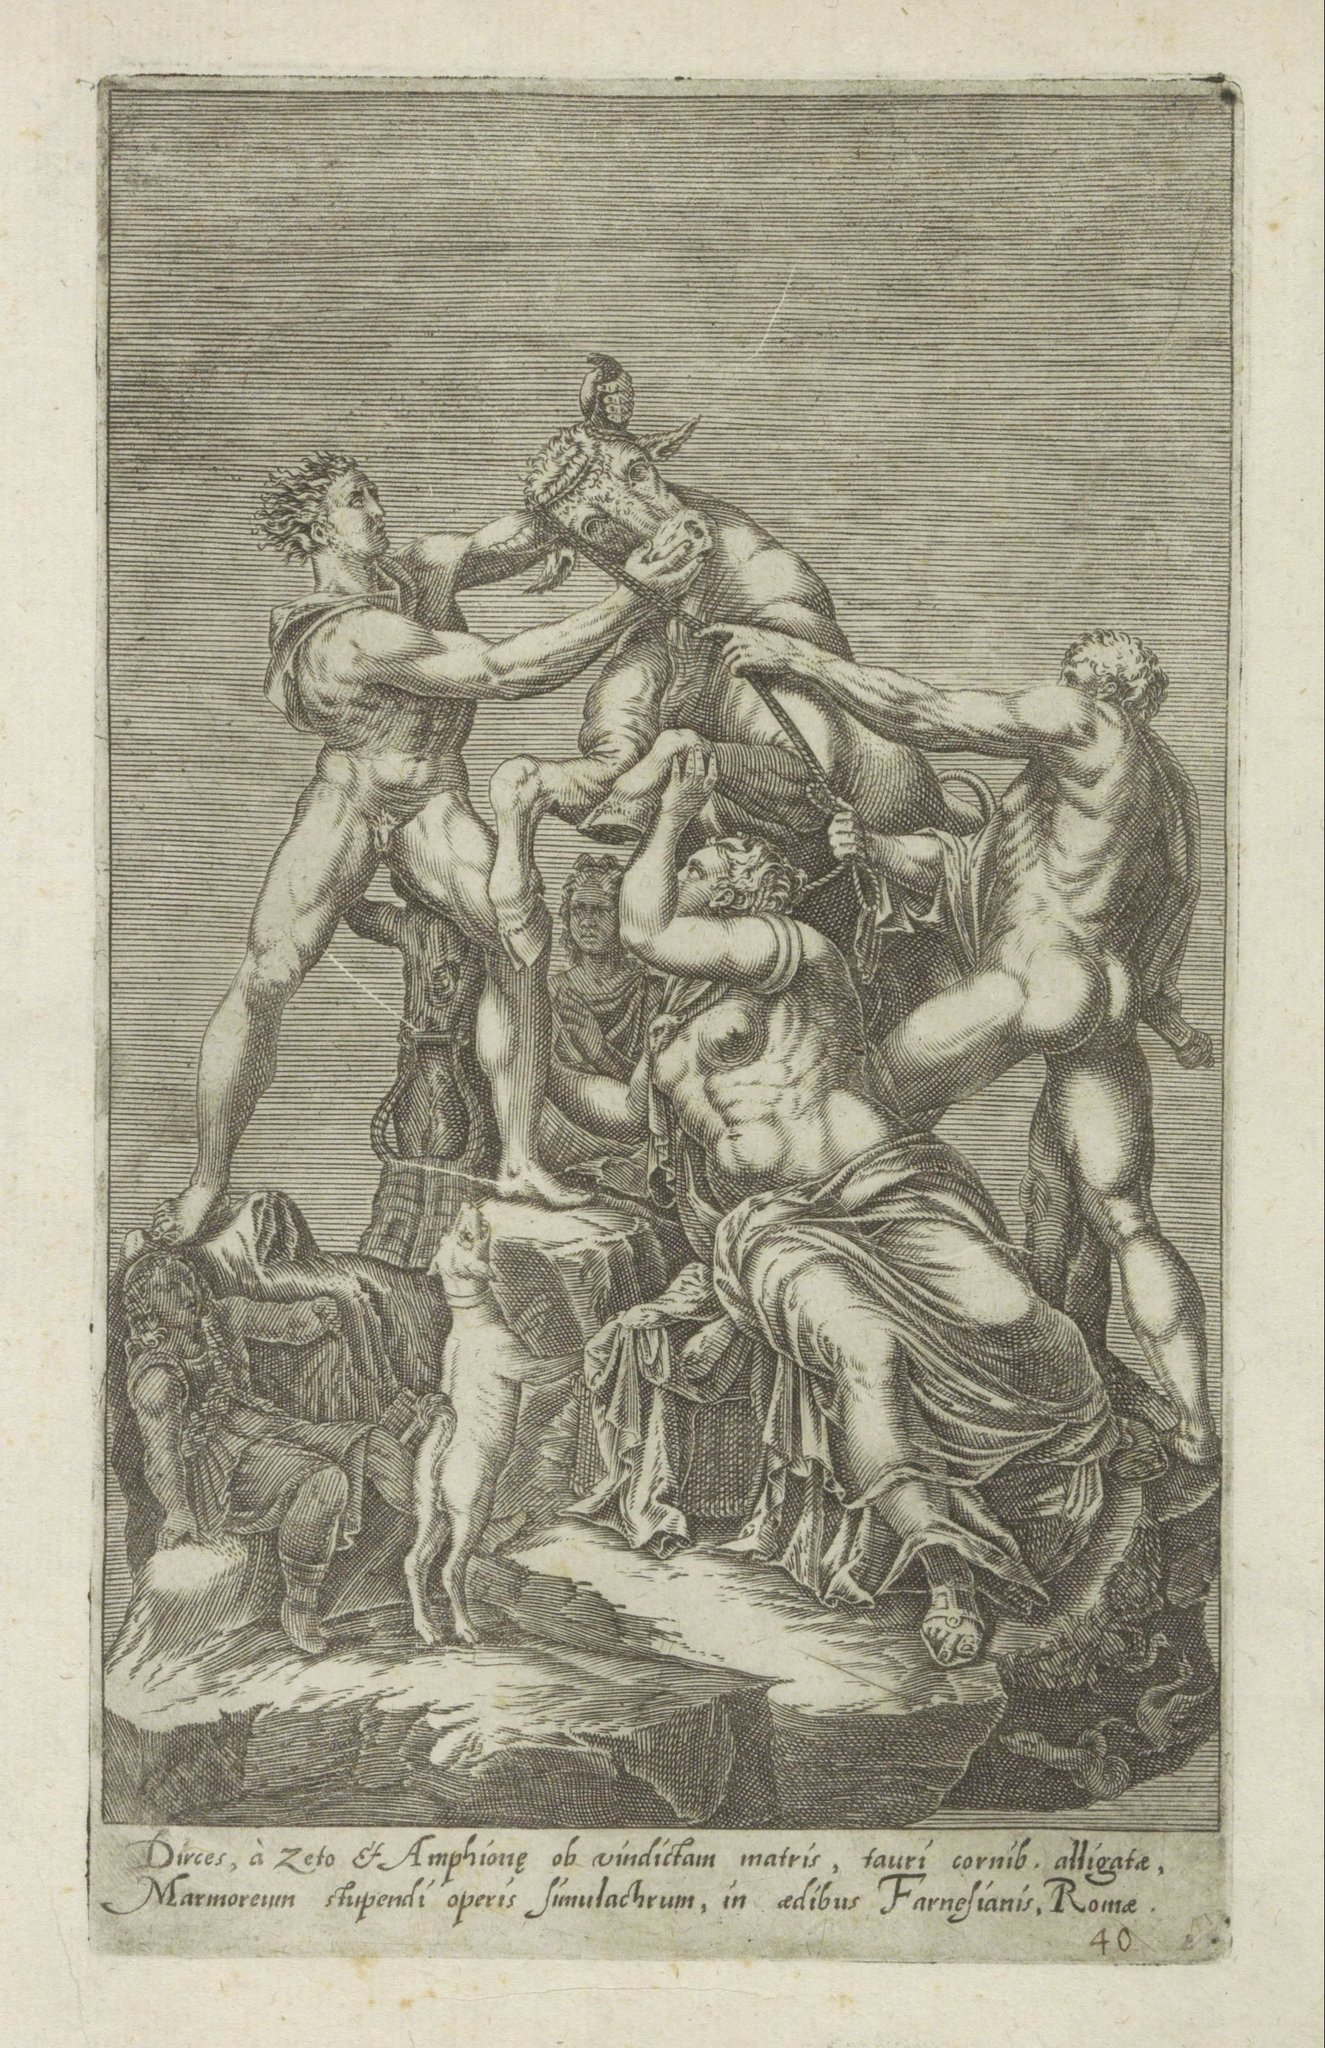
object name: album leaf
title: Sculptuur van Dirce die aan een stier wordt gebonden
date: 1584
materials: paper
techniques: engraving, intaglio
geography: rome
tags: piece of sculpture, reproduction of a piece of sculpture, amphion and zethus avenge their mother by tying dirce to the horns of a bull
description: Prent naar de antieke sculptuur die bekend staat als de Farnese Stier in het Museo Archeologico Nazionale Napoli te Napels. Deze prent maakt deel uit van een set van 79 prenten (+ titelprent) met voorstellingen van antieke sculpturen in Rome.